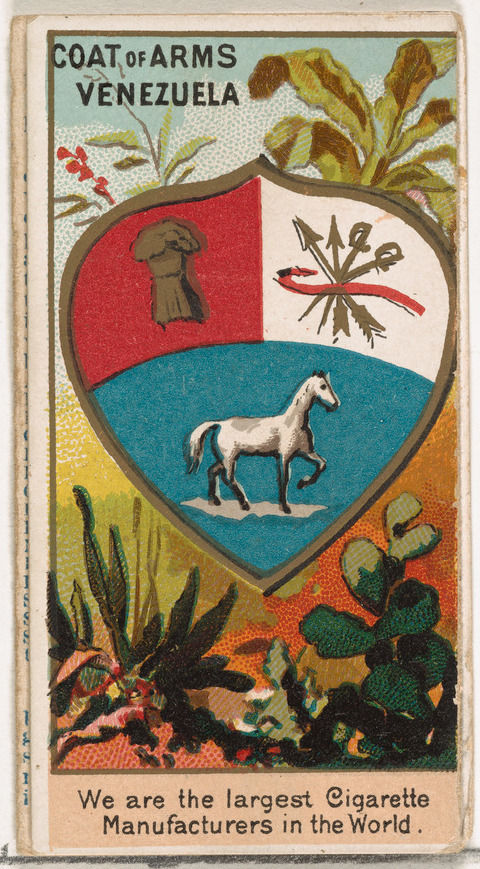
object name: print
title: President Guzman Blanco of Venezuela, from the Rulers, Flags, and Coats of Arms series (N126-2) issued by W. Duke, Sons & Co.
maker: w. duke, sons & co.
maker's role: publisher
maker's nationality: american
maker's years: 1870-1920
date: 1888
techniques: color lithograph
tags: coat of arms